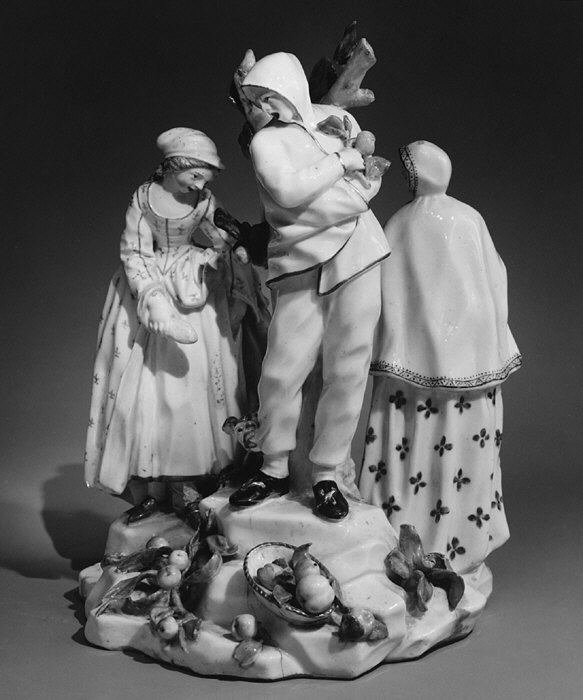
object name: group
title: Apple stealers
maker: capodimonte porcelain manufactory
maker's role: manufactory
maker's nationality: italian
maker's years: 1740-1759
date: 1747-1749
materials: soft paste porcelain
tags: apples,boys,women,dogs